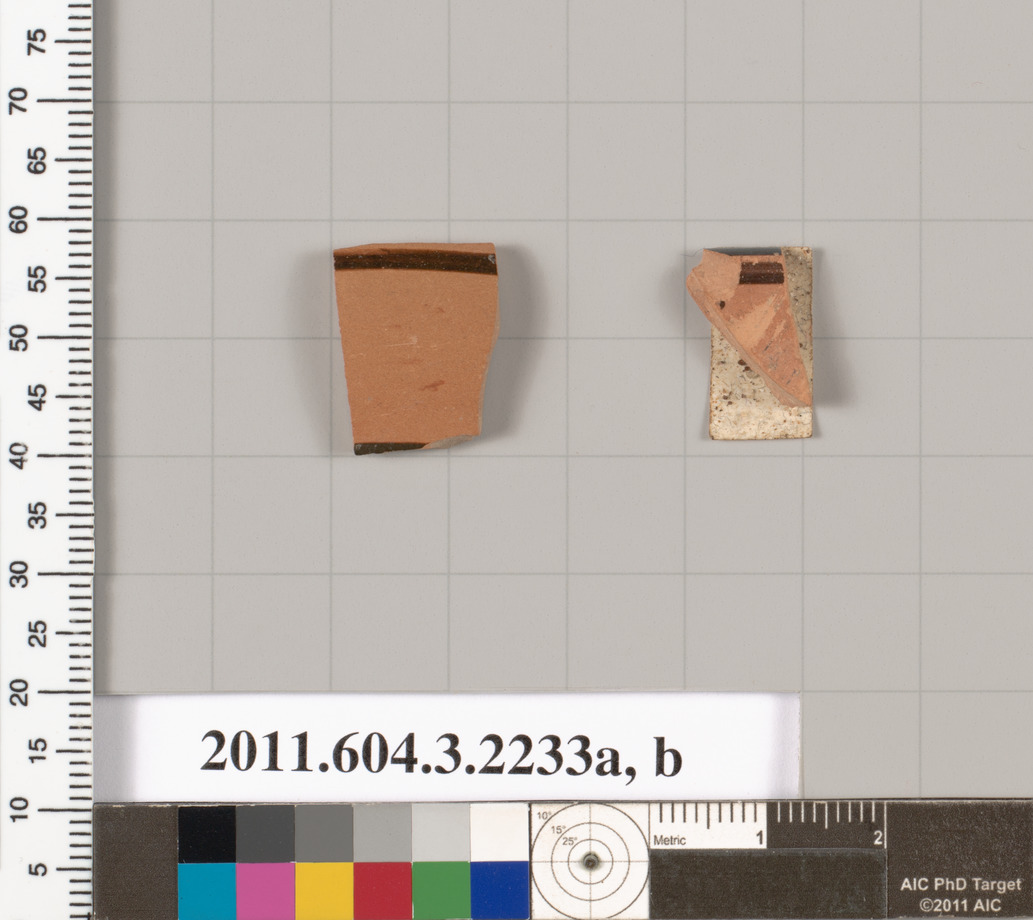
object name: kylix fragment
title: Terracotta rim fragments of kylikes (drinking cups)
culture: greek, attic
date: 600-401 BCE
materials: terracotta